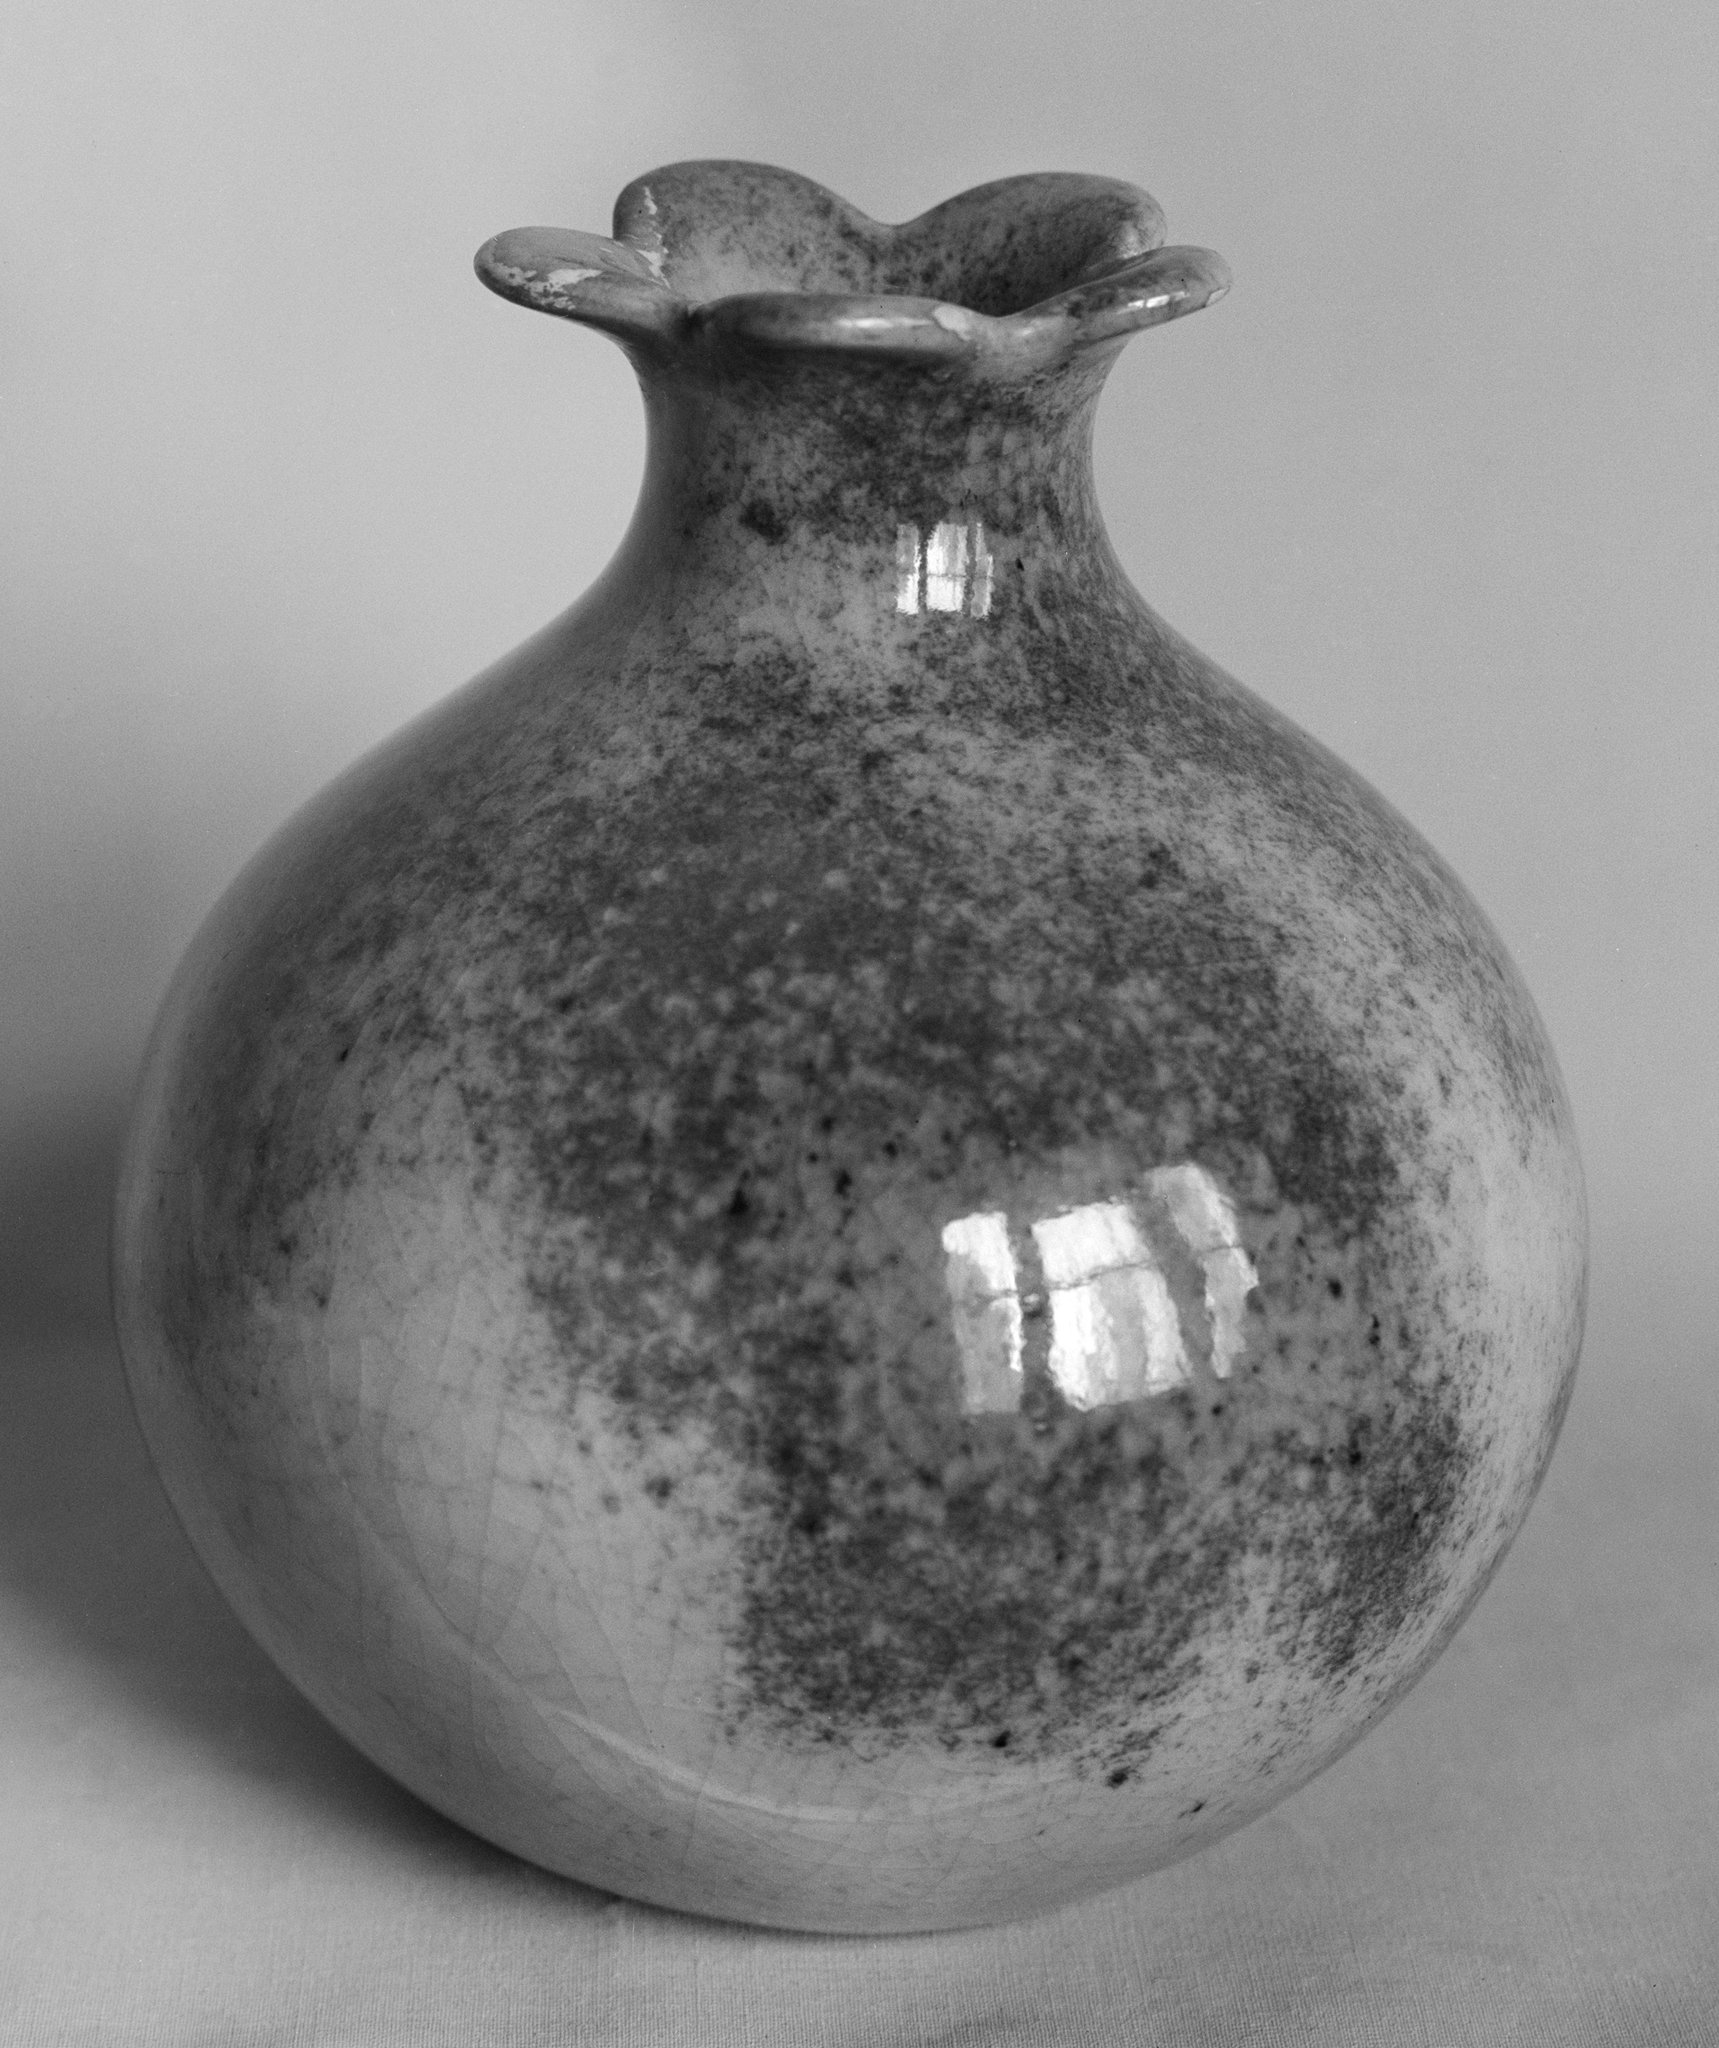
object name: vase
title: Pomegranate vase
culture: chinese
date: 1801-1900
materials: glaze, porcelain